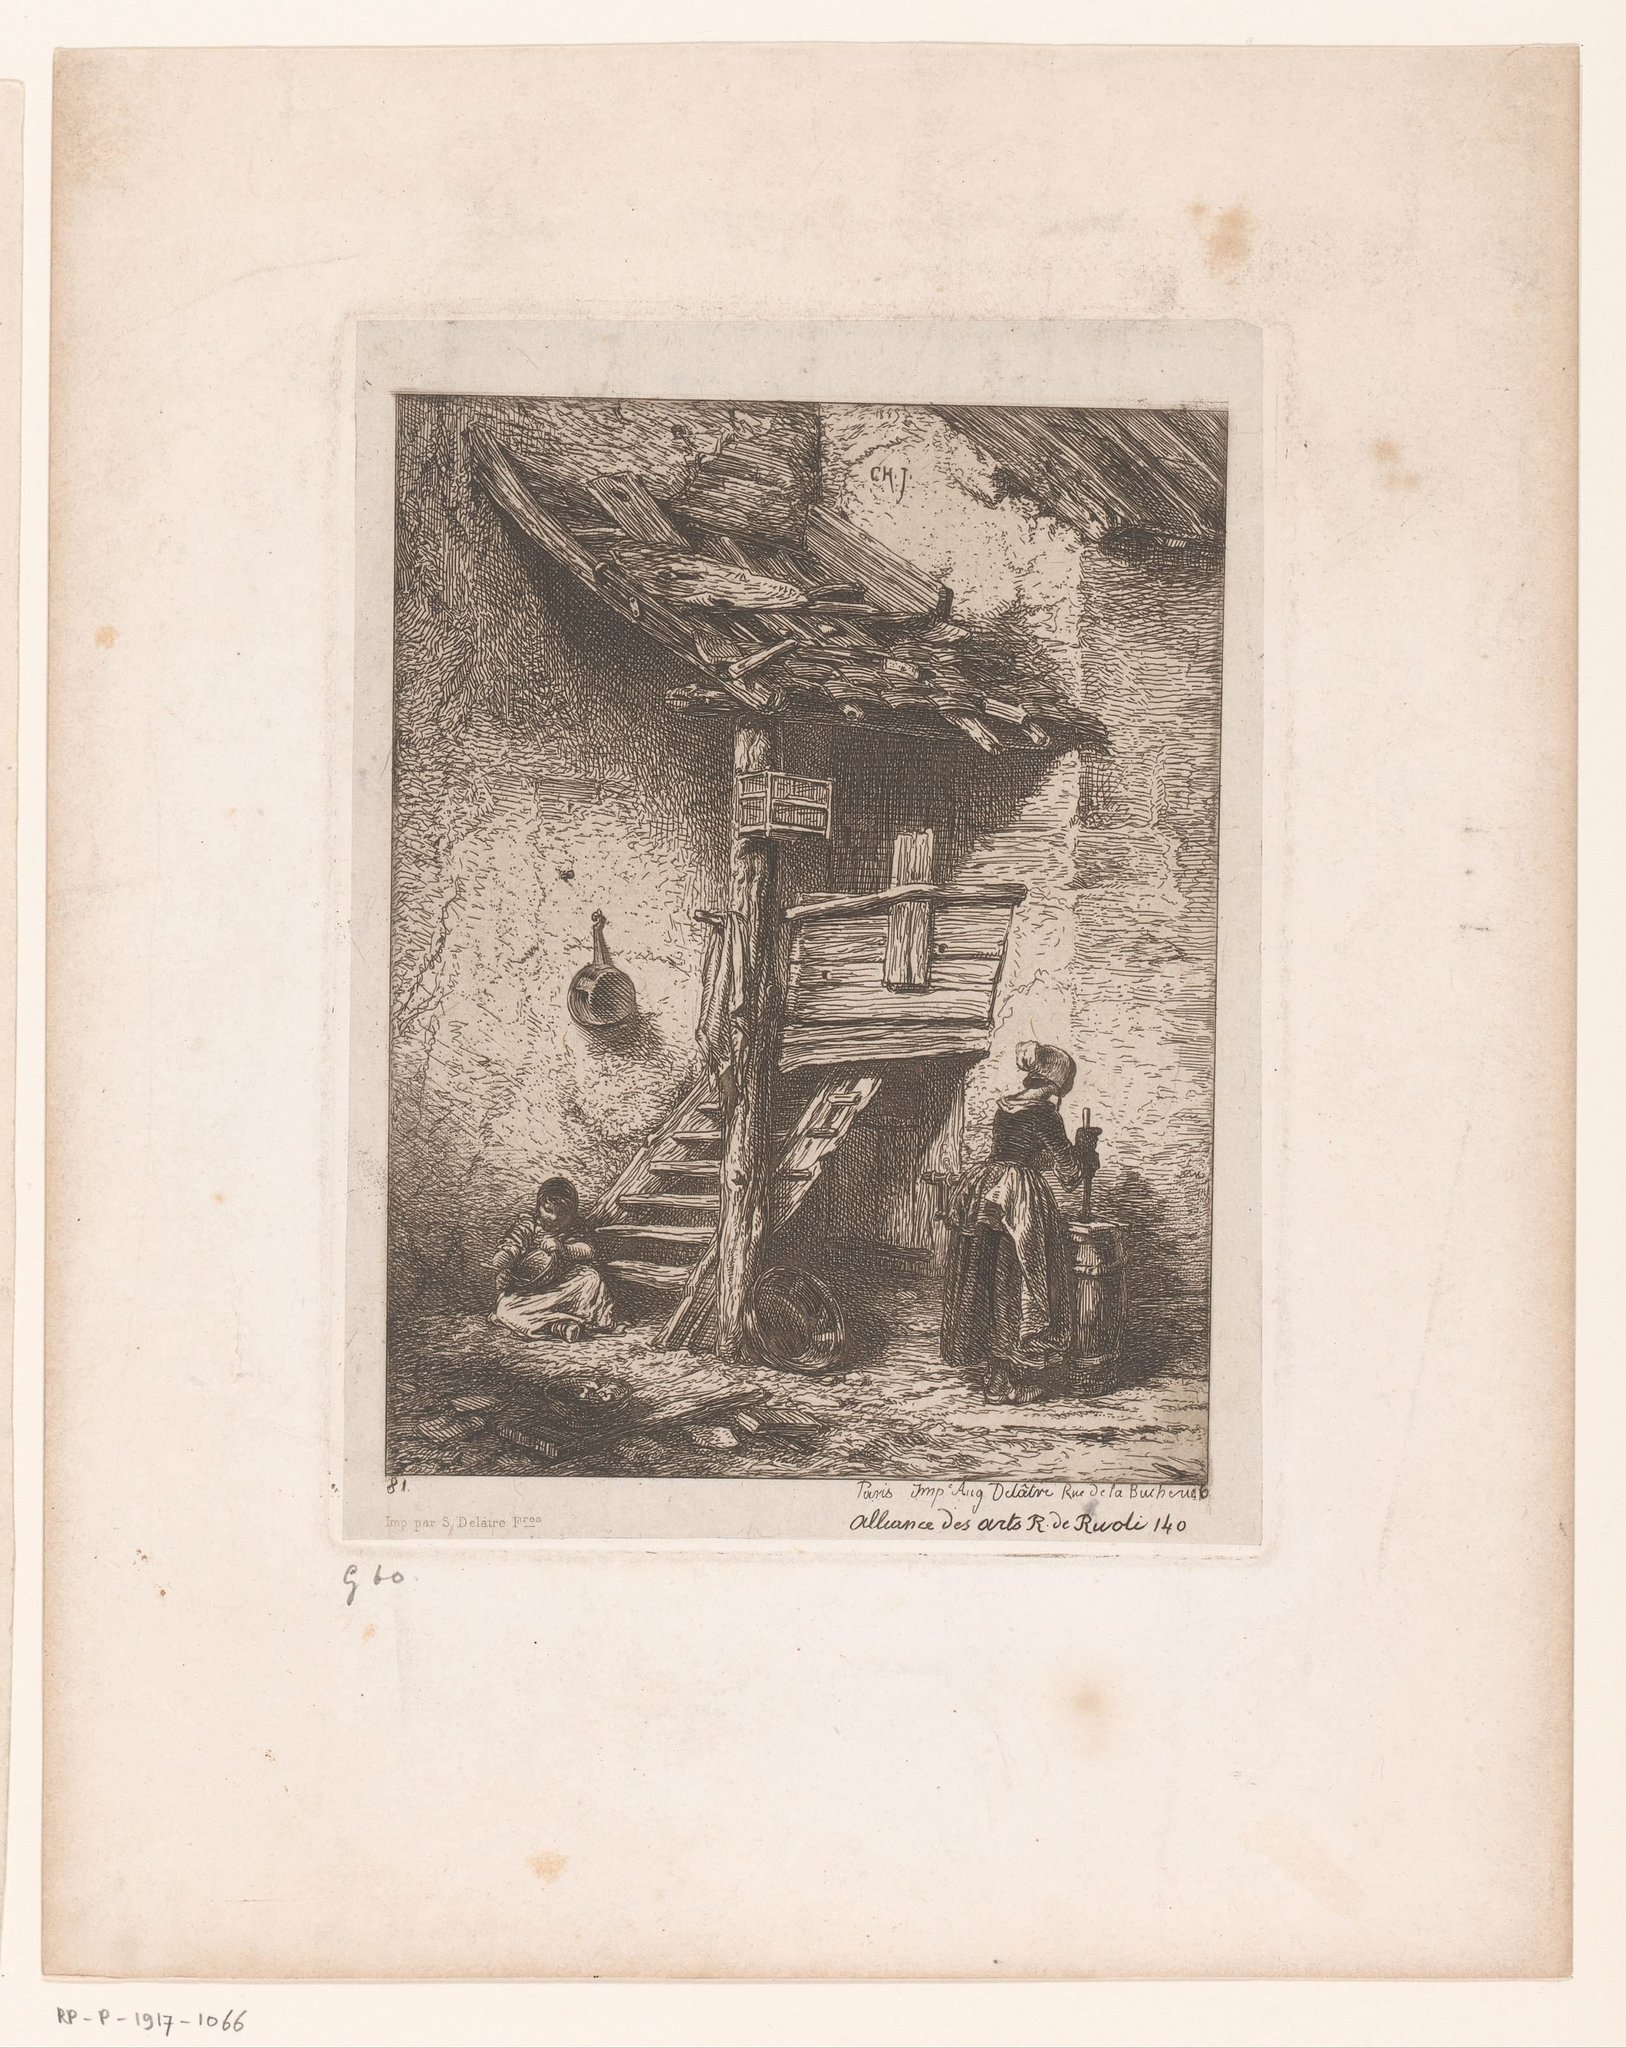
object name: print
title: Binnenplaats met een kind en een karnende vrouw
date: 1845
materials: paper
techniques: etching, roulette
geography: paris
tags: courtyard, churning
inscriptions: collector's mark: Lugt 2233